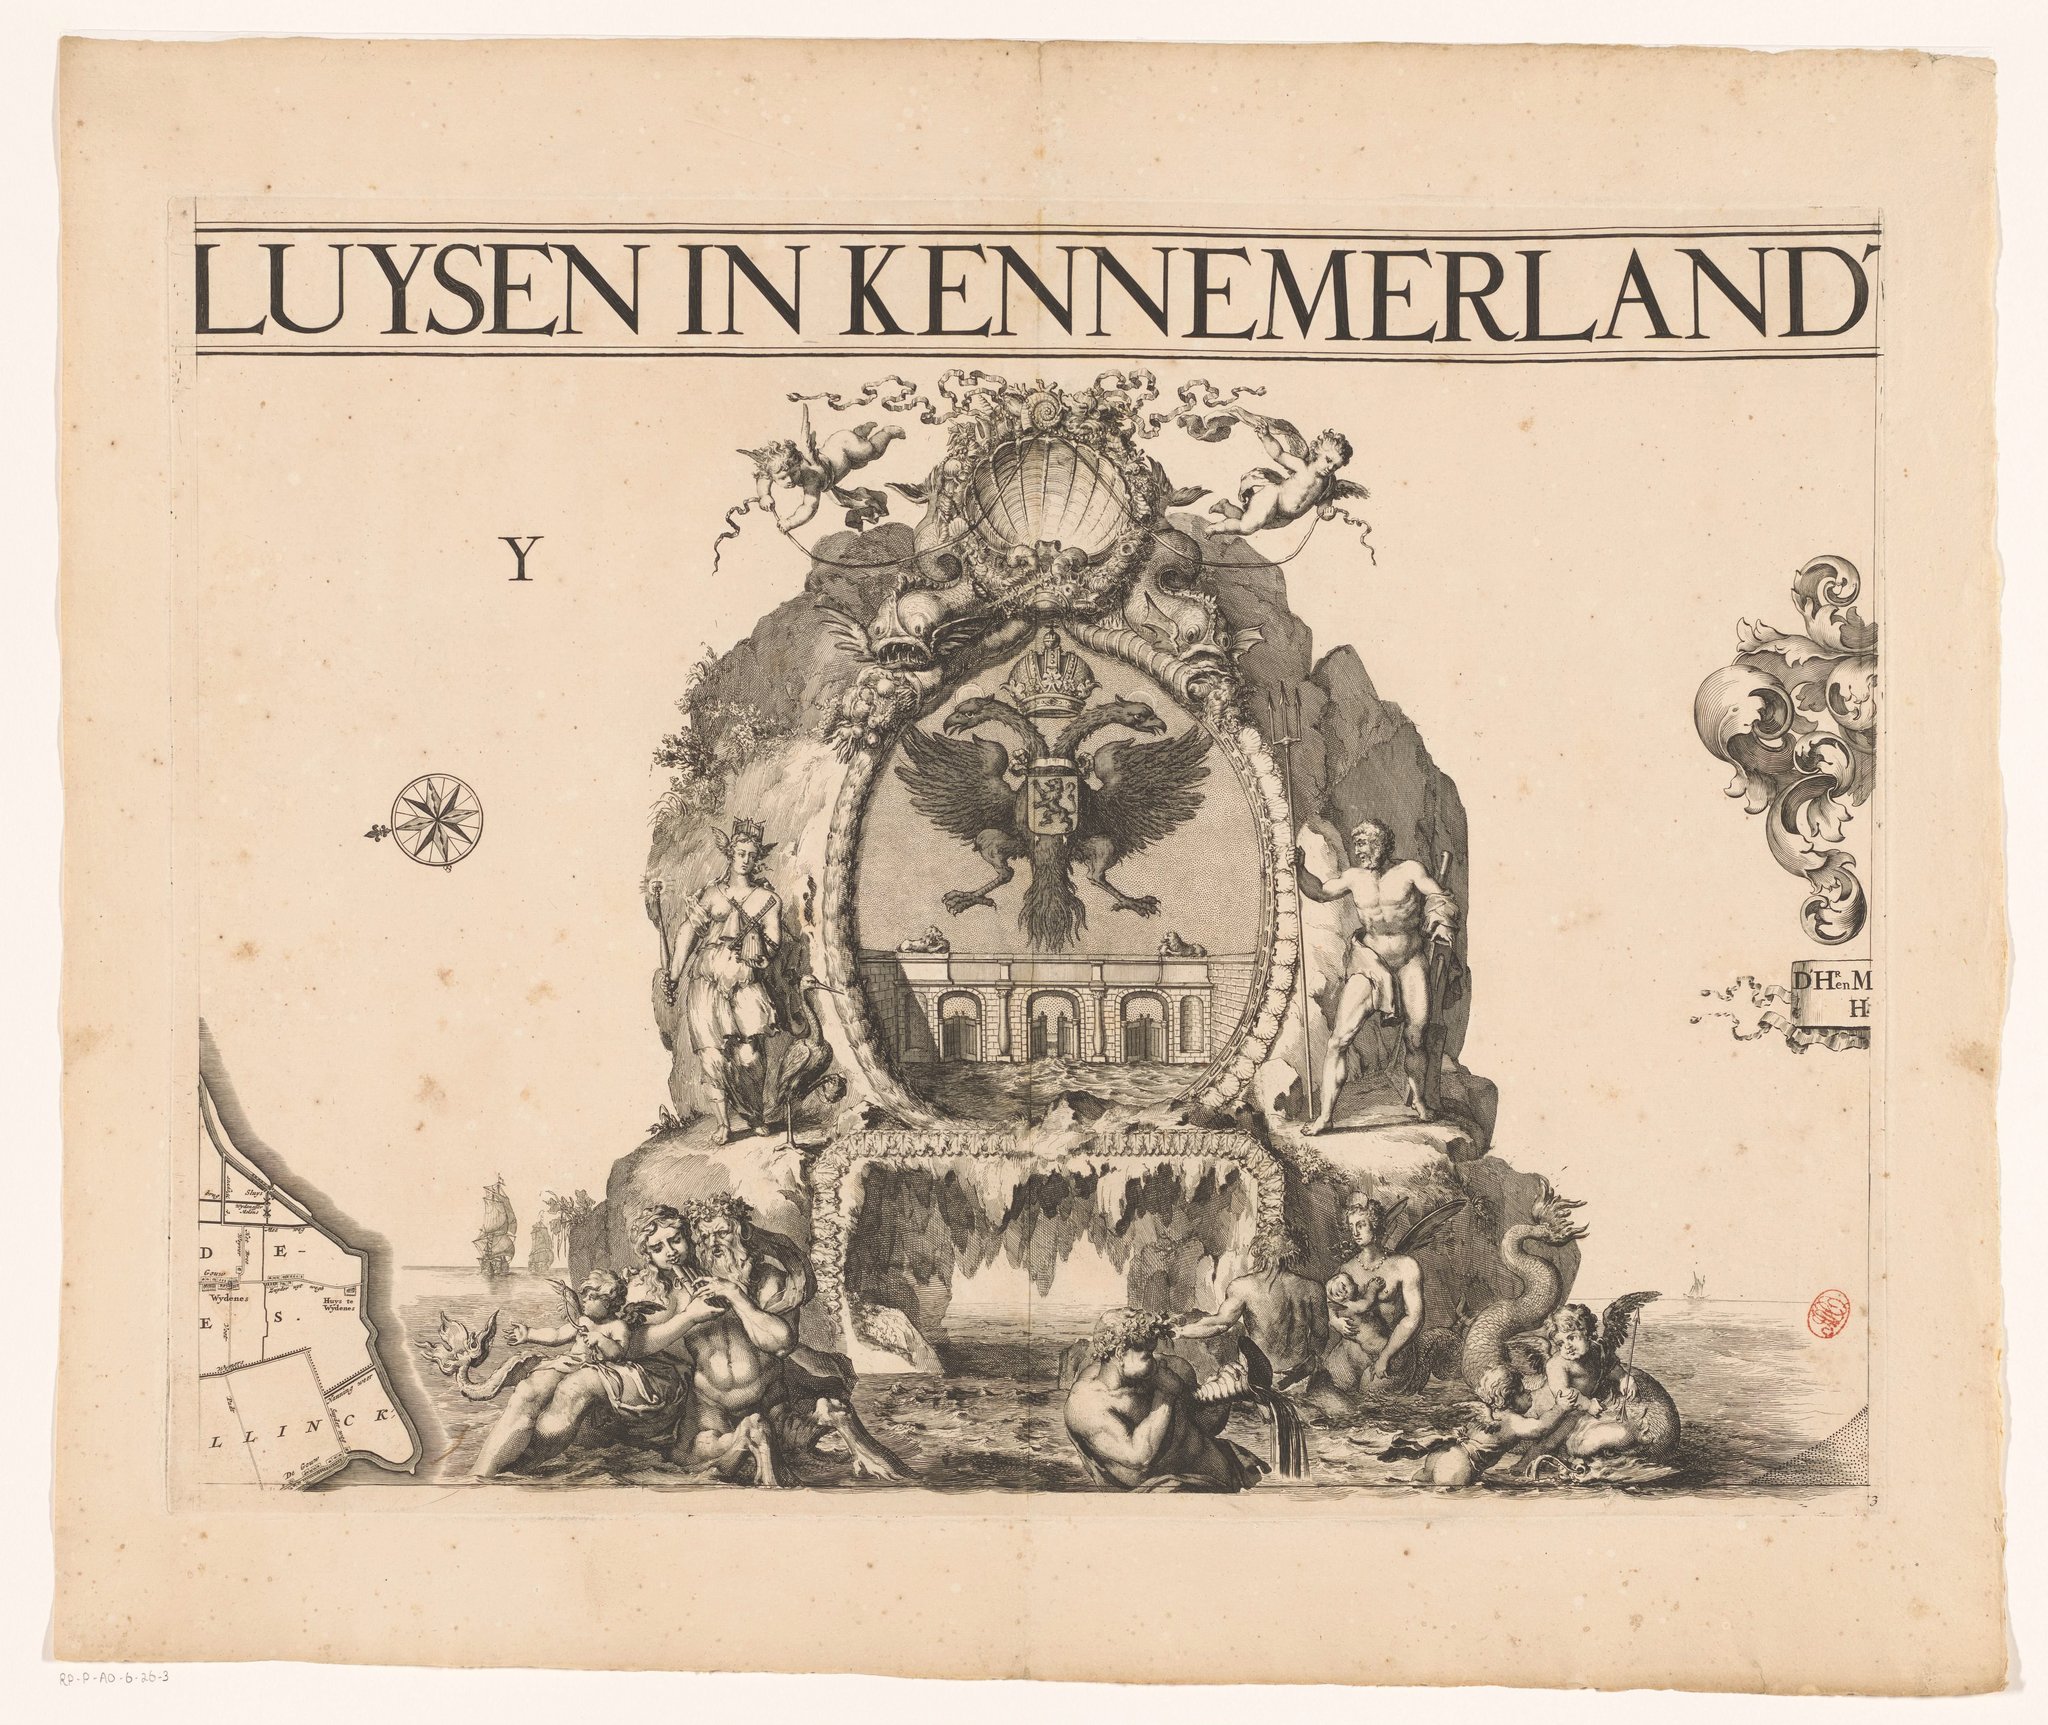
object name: map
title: Kaart van Kennemerland en West-Friesland (derde deel)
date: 1680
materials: paper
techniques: engraving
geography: amsterdam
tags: shore-birds and wading-birds: crane, (story of) neptune (poseidon), coat of arms (as symbol of the state, etc.), triton(s), maps of separate countries or regions, merman - aa - mermaid, siren, river-gods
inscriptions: collector's mark: Lugt 195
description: Derde deel van een kaart van Kennemerland en West-Friesland. Rechtsonder genummerd: 3.